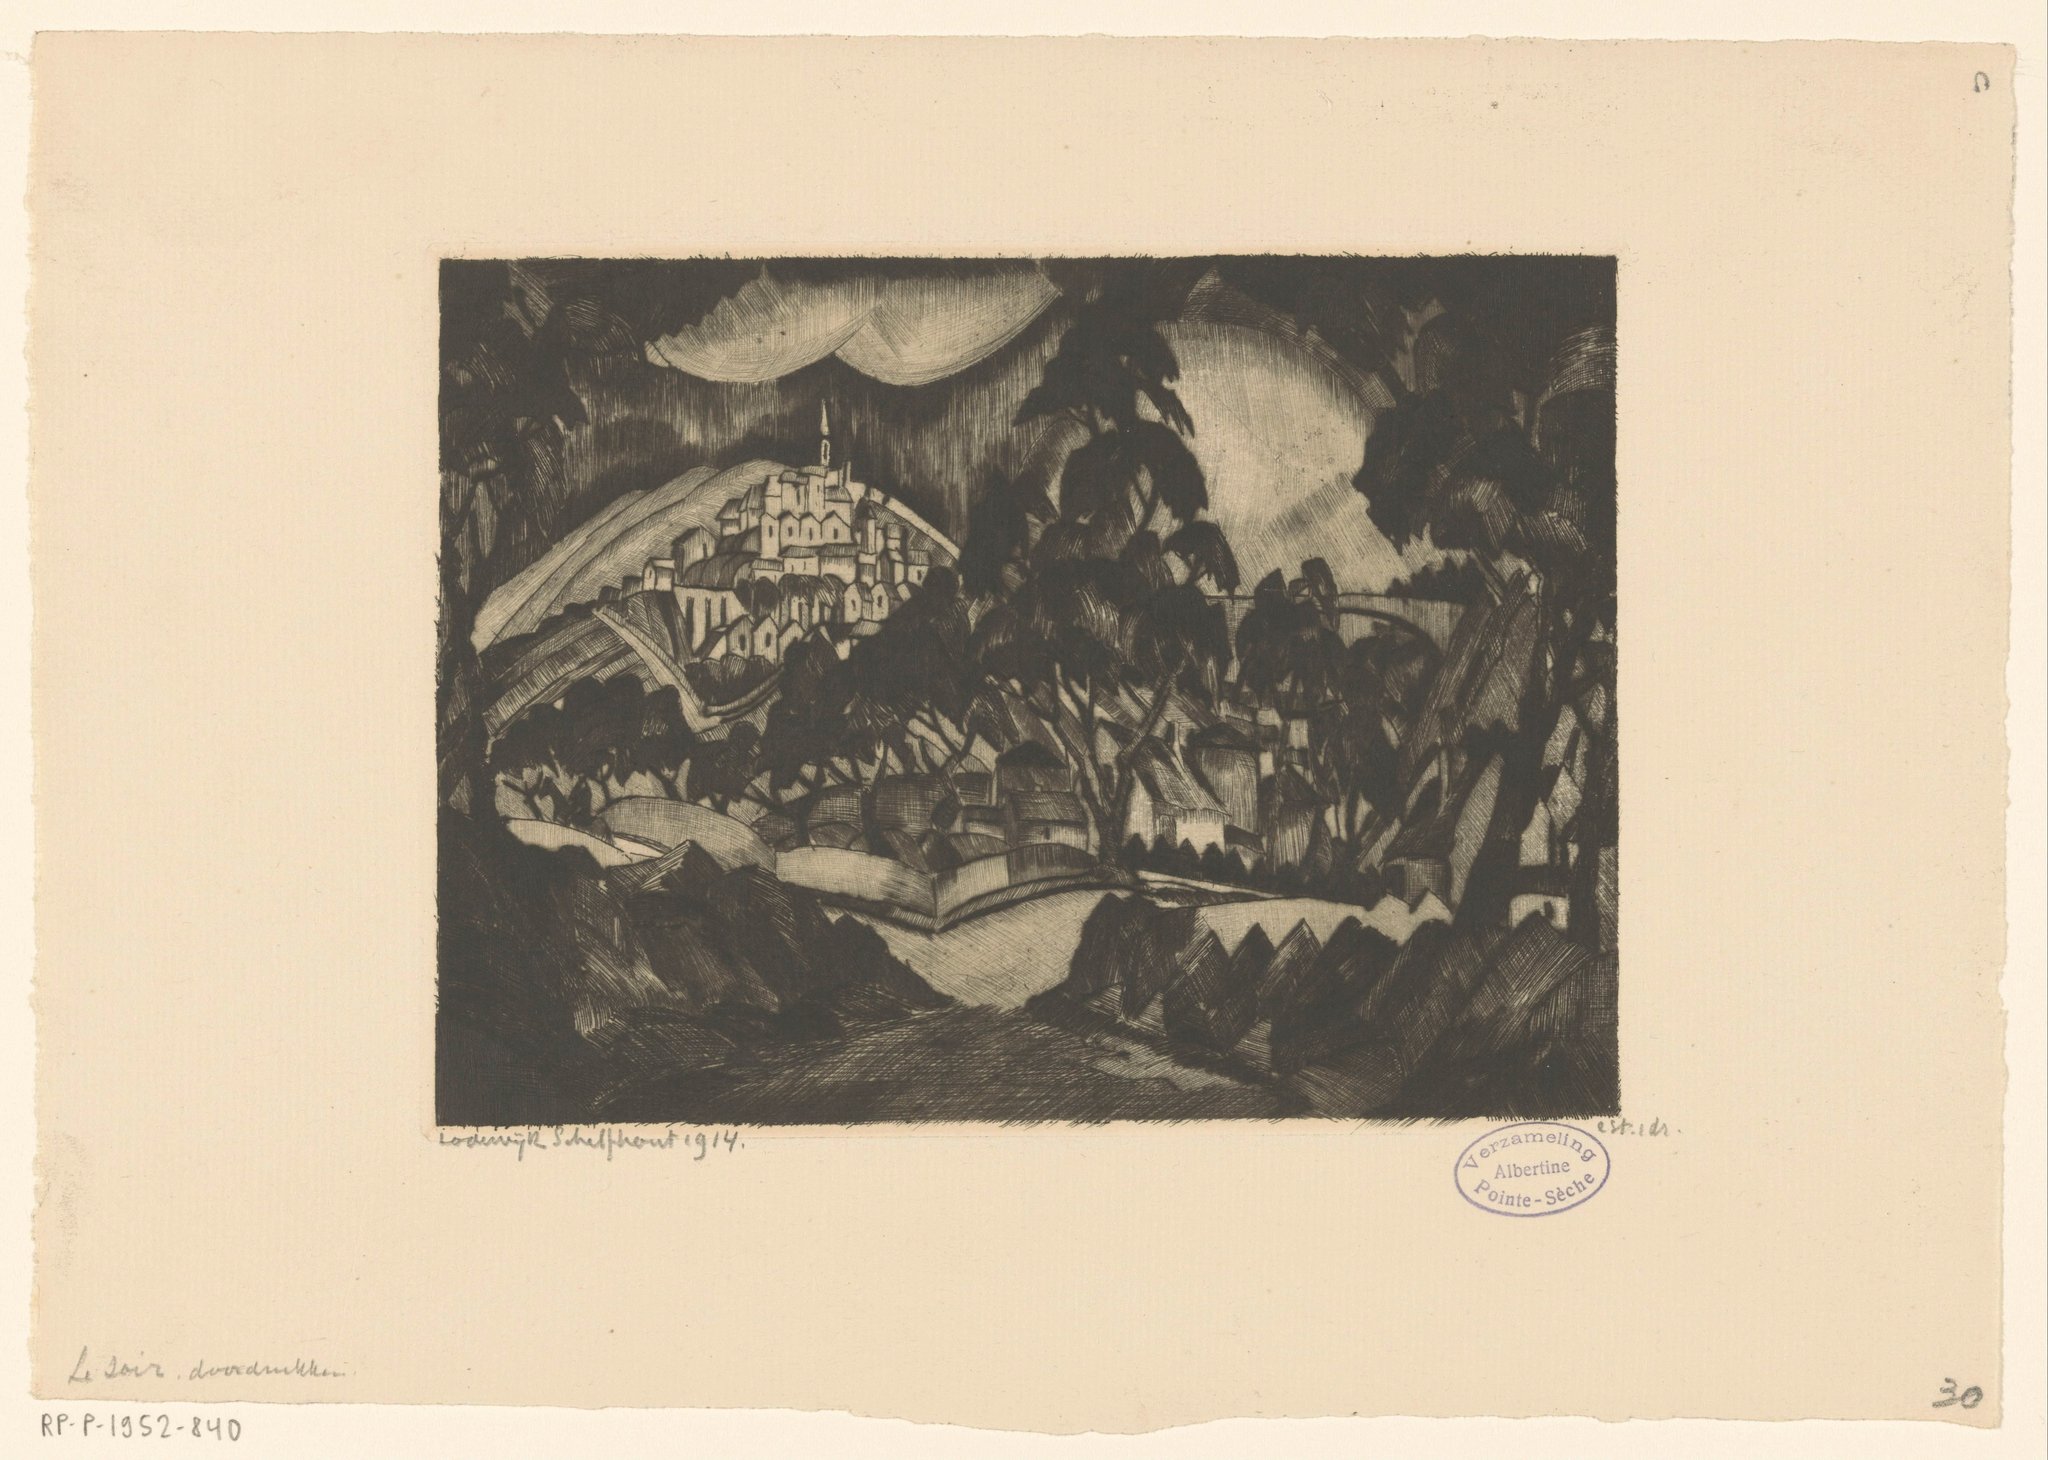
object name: print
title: Heuvellandschap met bomen en bebouwing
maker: lodewijk schelfhout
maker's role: draughtsman, print maker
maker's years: 1881-1943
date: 1914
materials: paper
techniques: drypoint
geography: netherlands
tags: prospect of village, silhouette of village, low hill country, evening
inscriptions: collector's mark: Lugt 2228, collector's mark: Lugt 2760, inscription: ‘doordrukken’, collector's mark: Lugt 5i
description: Op de achtergrond een nederzetting met kerk op een heuvel.